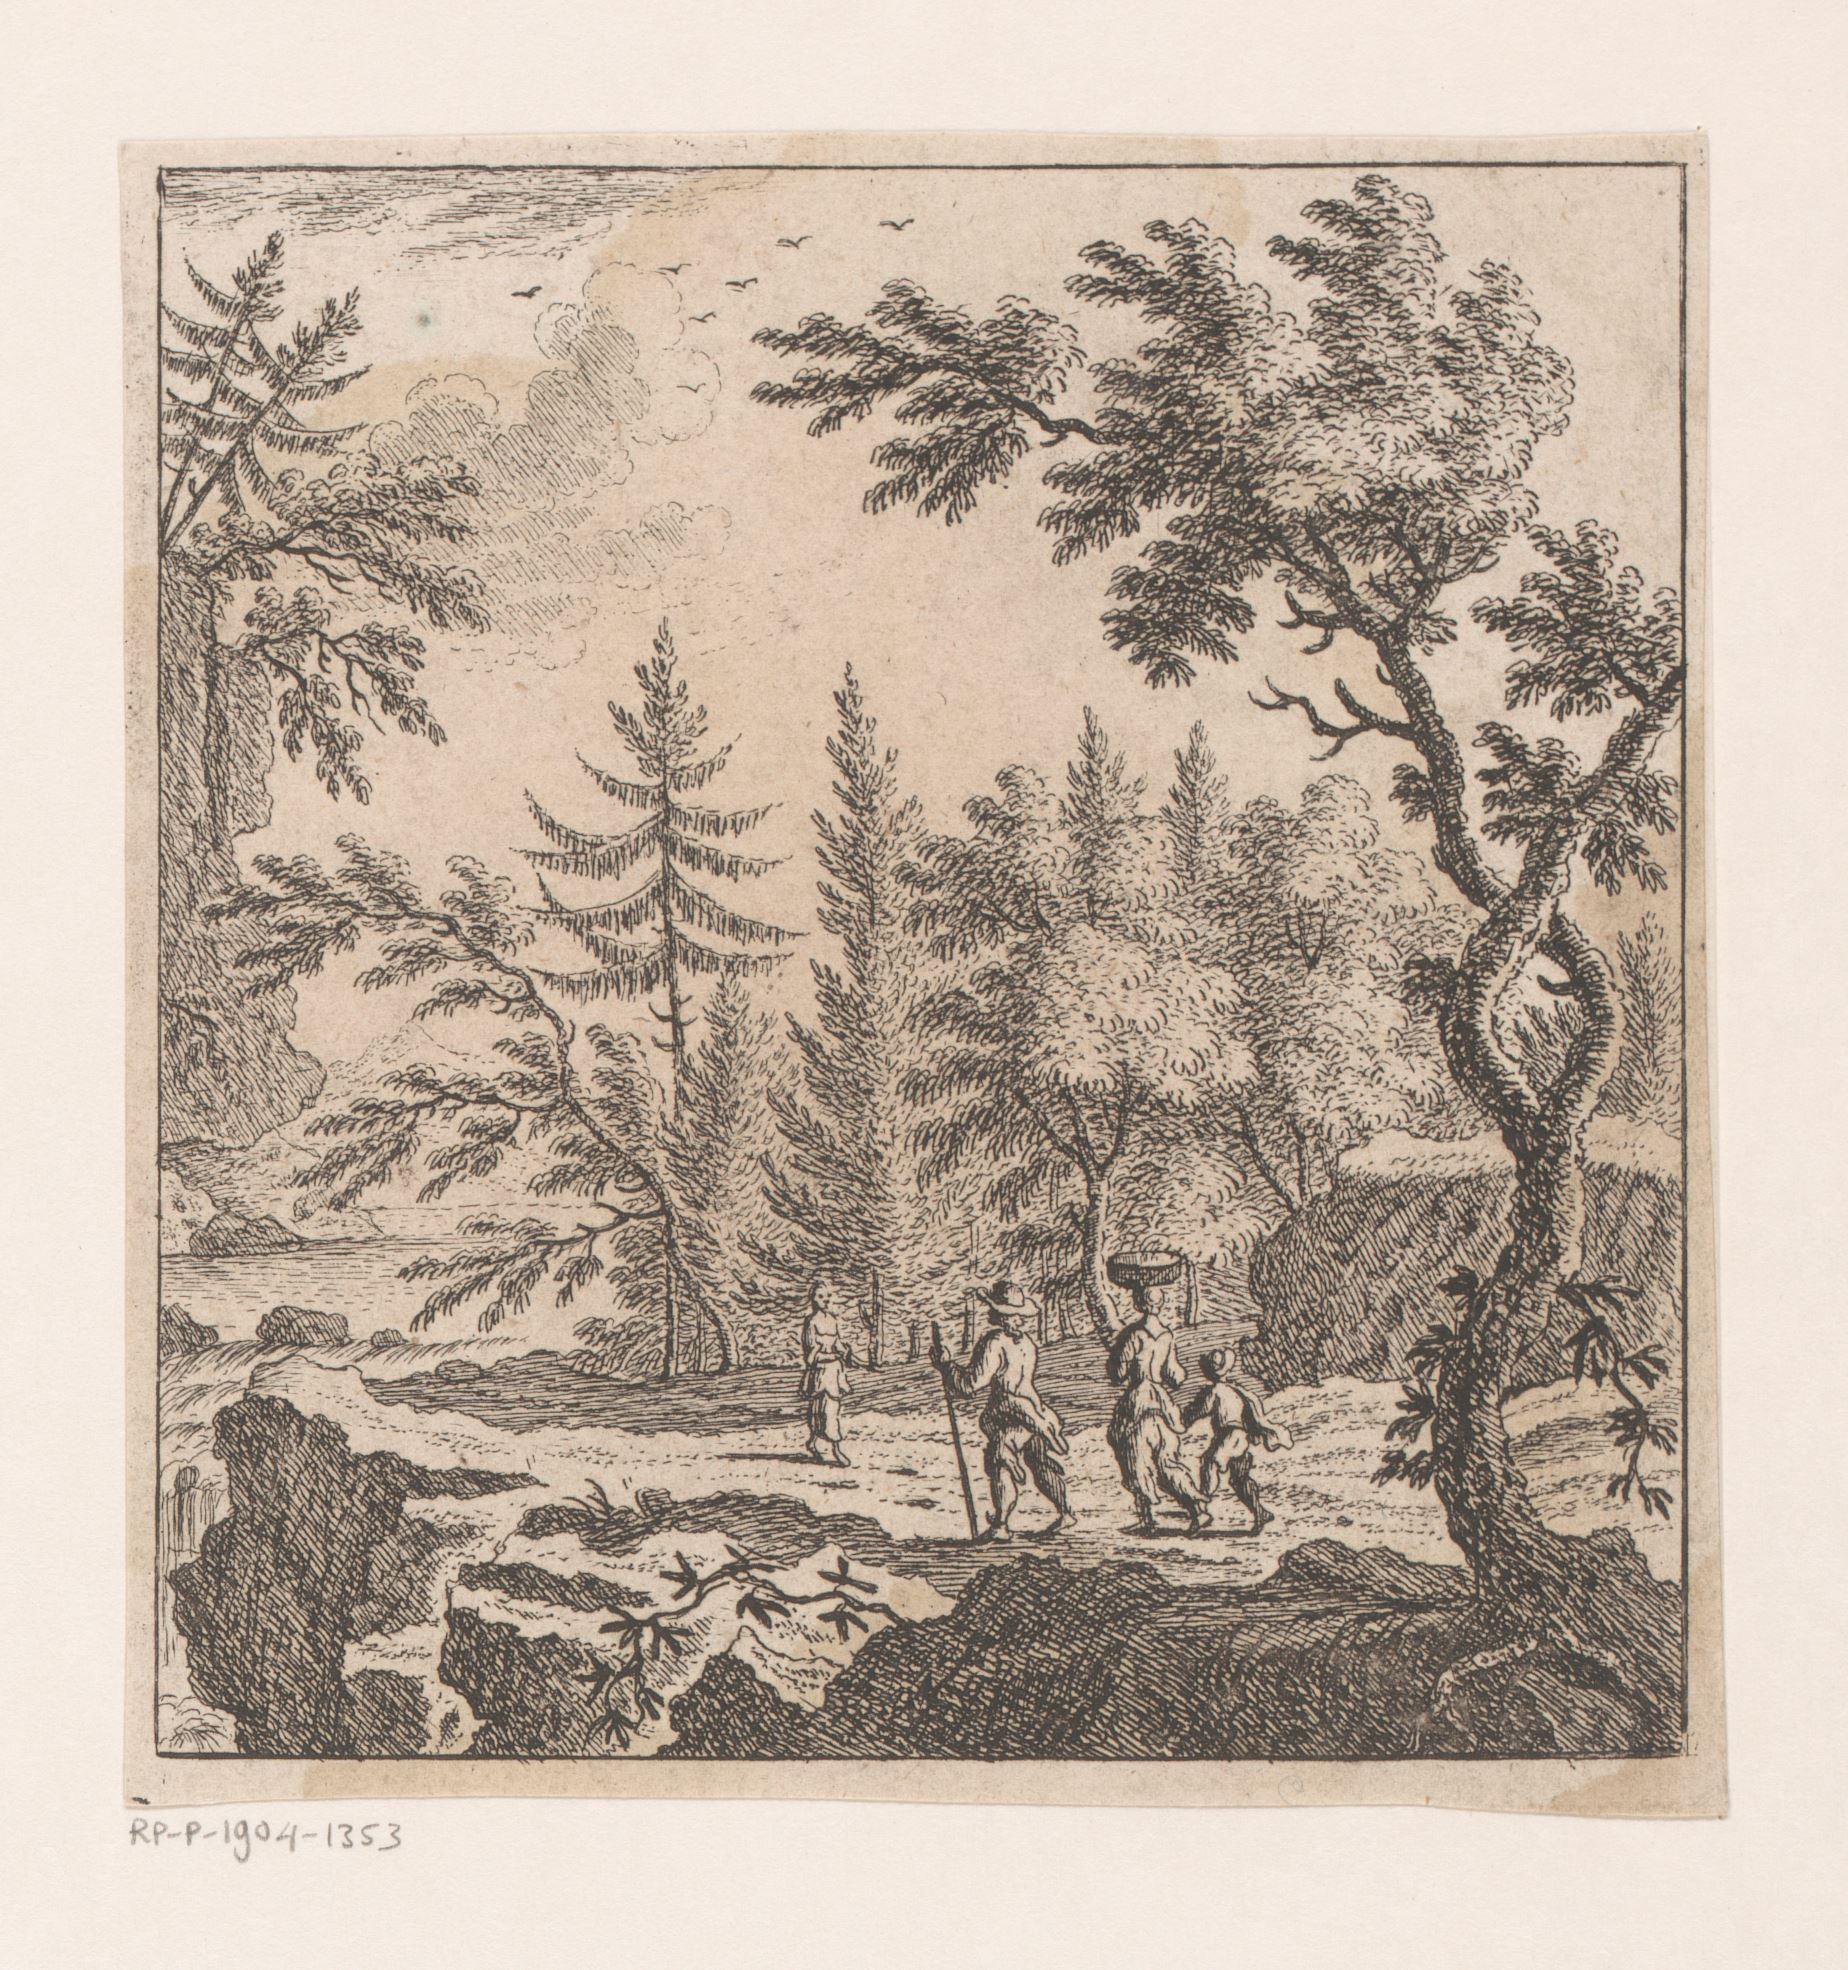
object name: print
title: Landschap met een waterval en vier lopende figuren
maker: johann caspar ulinger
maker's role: painter, print maker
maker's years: 1703-1768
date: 1713-1768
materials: paper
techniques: etching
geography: switzerland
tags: waterfall, forest, wood, 'en route', traveller under way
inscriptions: collector's mark: Lugt 2228